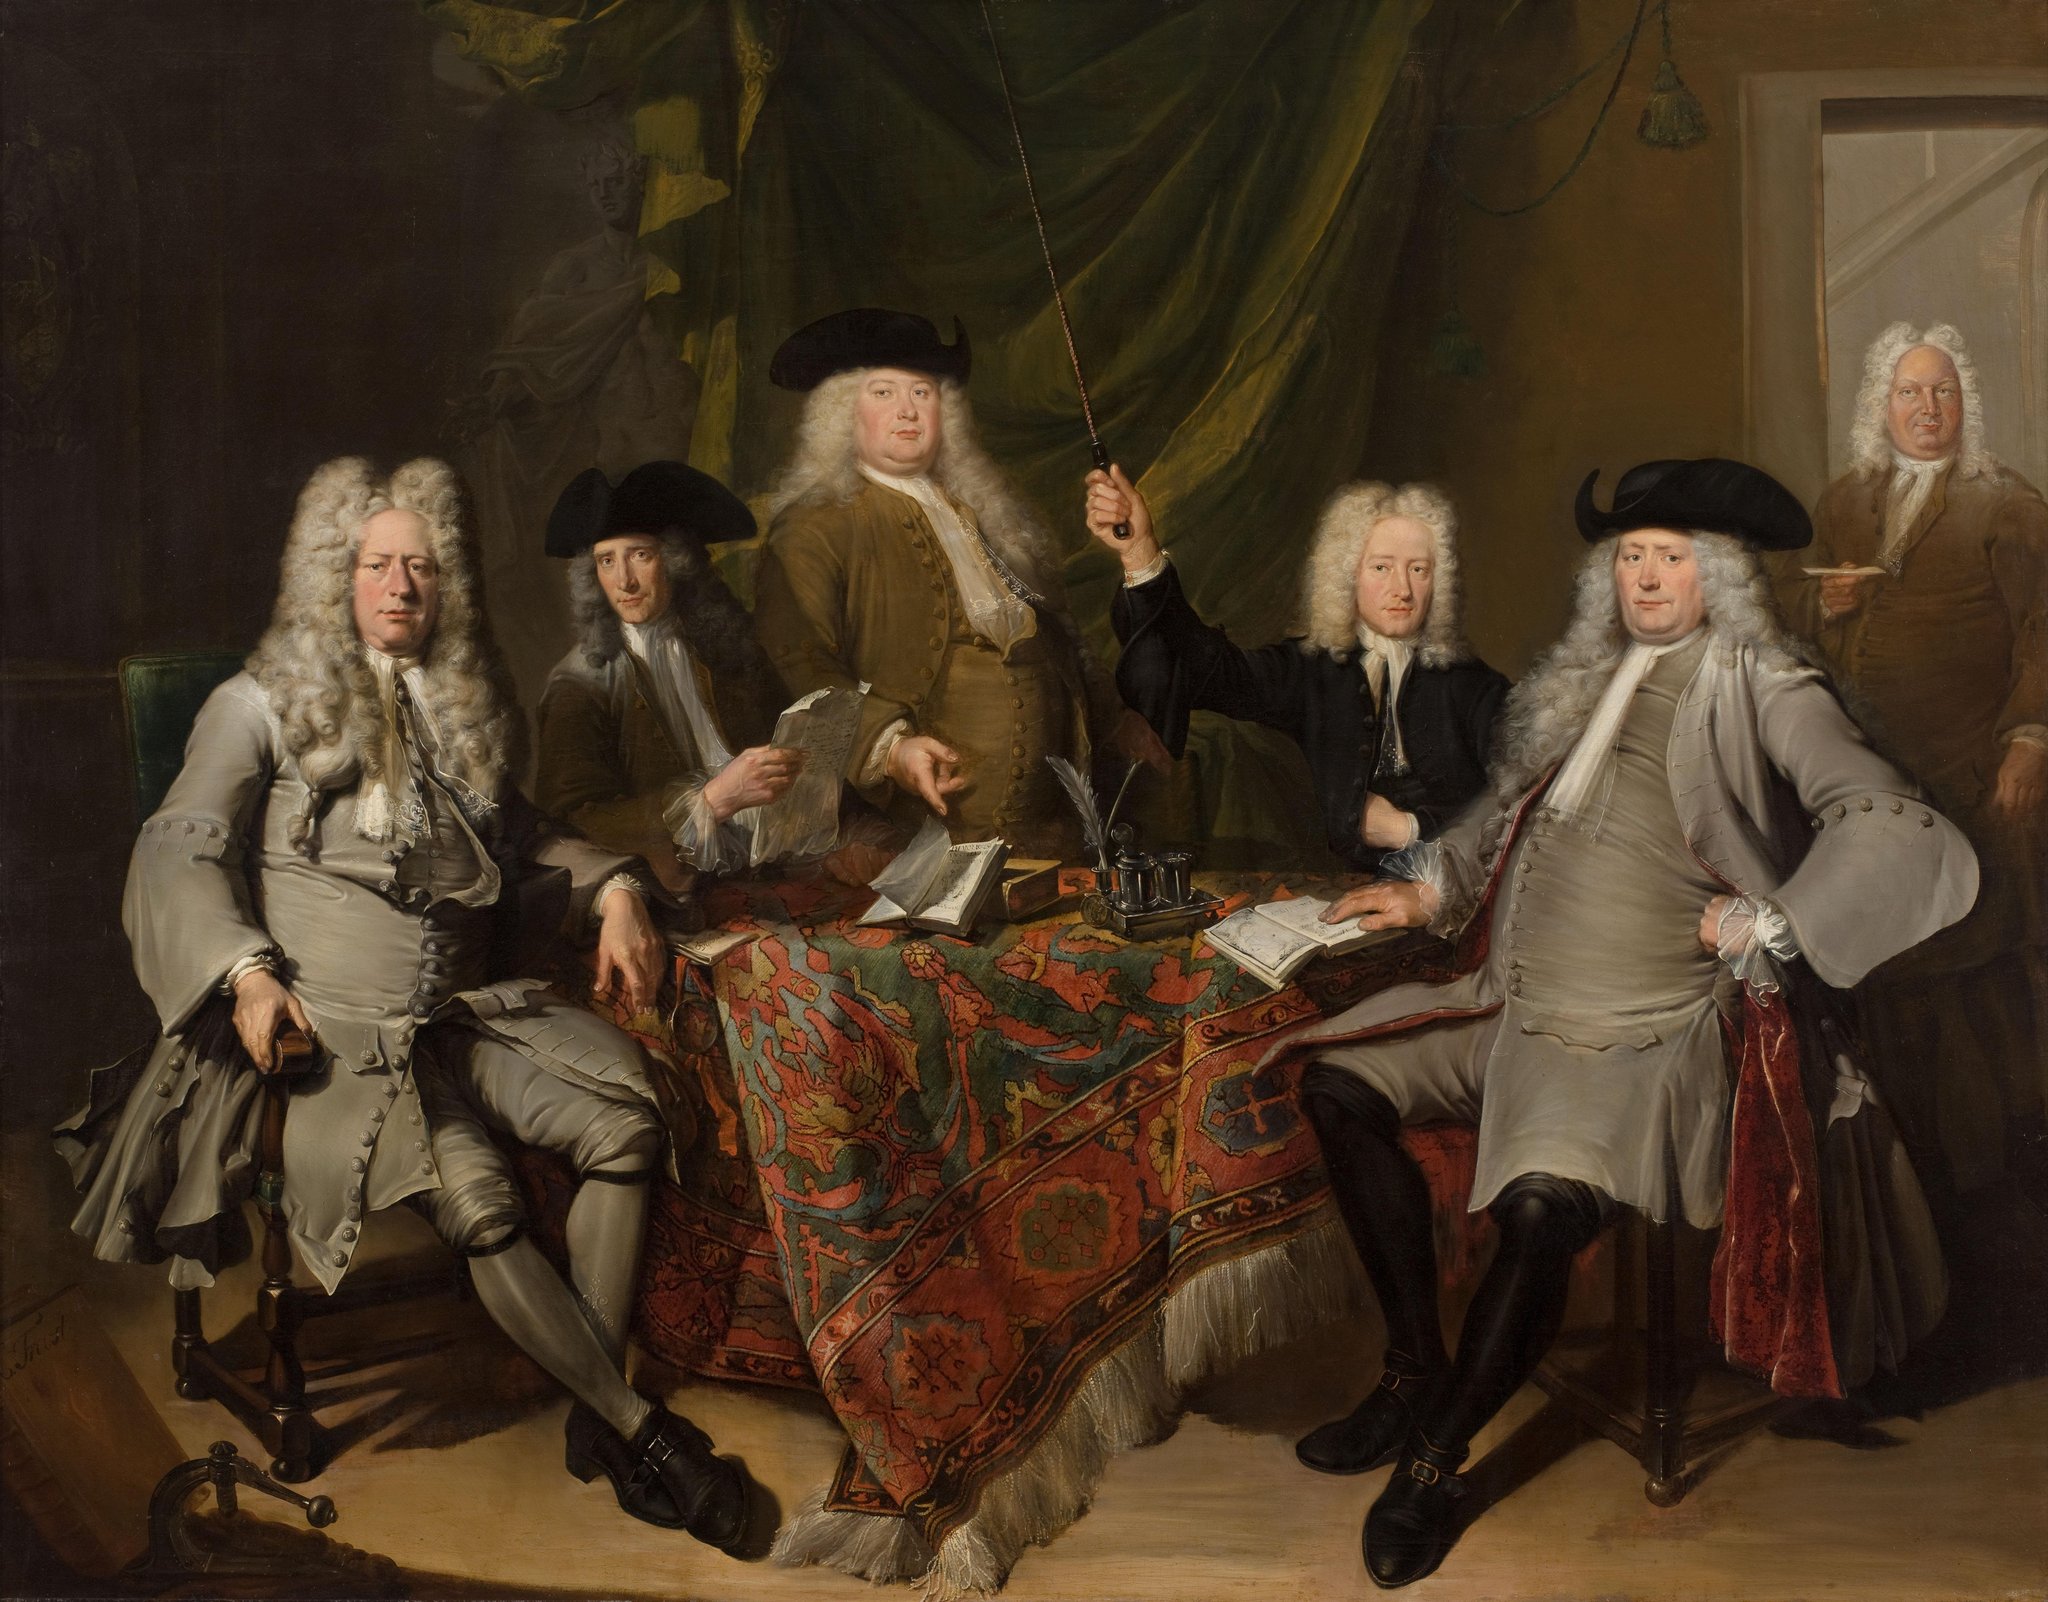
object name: painting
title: Portrait of the Inspectors of the Collegium Medicum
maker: cornelis troost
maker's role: draughtsman, painter, print maker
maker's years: 1696-1750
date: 1724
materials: canvas, oil, paint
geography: amsterdam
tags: officers trusted with control of quality, amsterdam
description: The Collegium Medicum consisted of doctors and apothecaries and oversaw the practice of medicine in Amsterdam. The second man from the left, apothecary Jeronimo de Bosch, is known to have supplied the medicine chest to the slave ship Leusden, which ran aground off Suriname in 1738. This shipwreck became infamous because sailors locked the hatches of the lower deck. Consequently, 664 West-African men, women and children were trapped inside and perished.